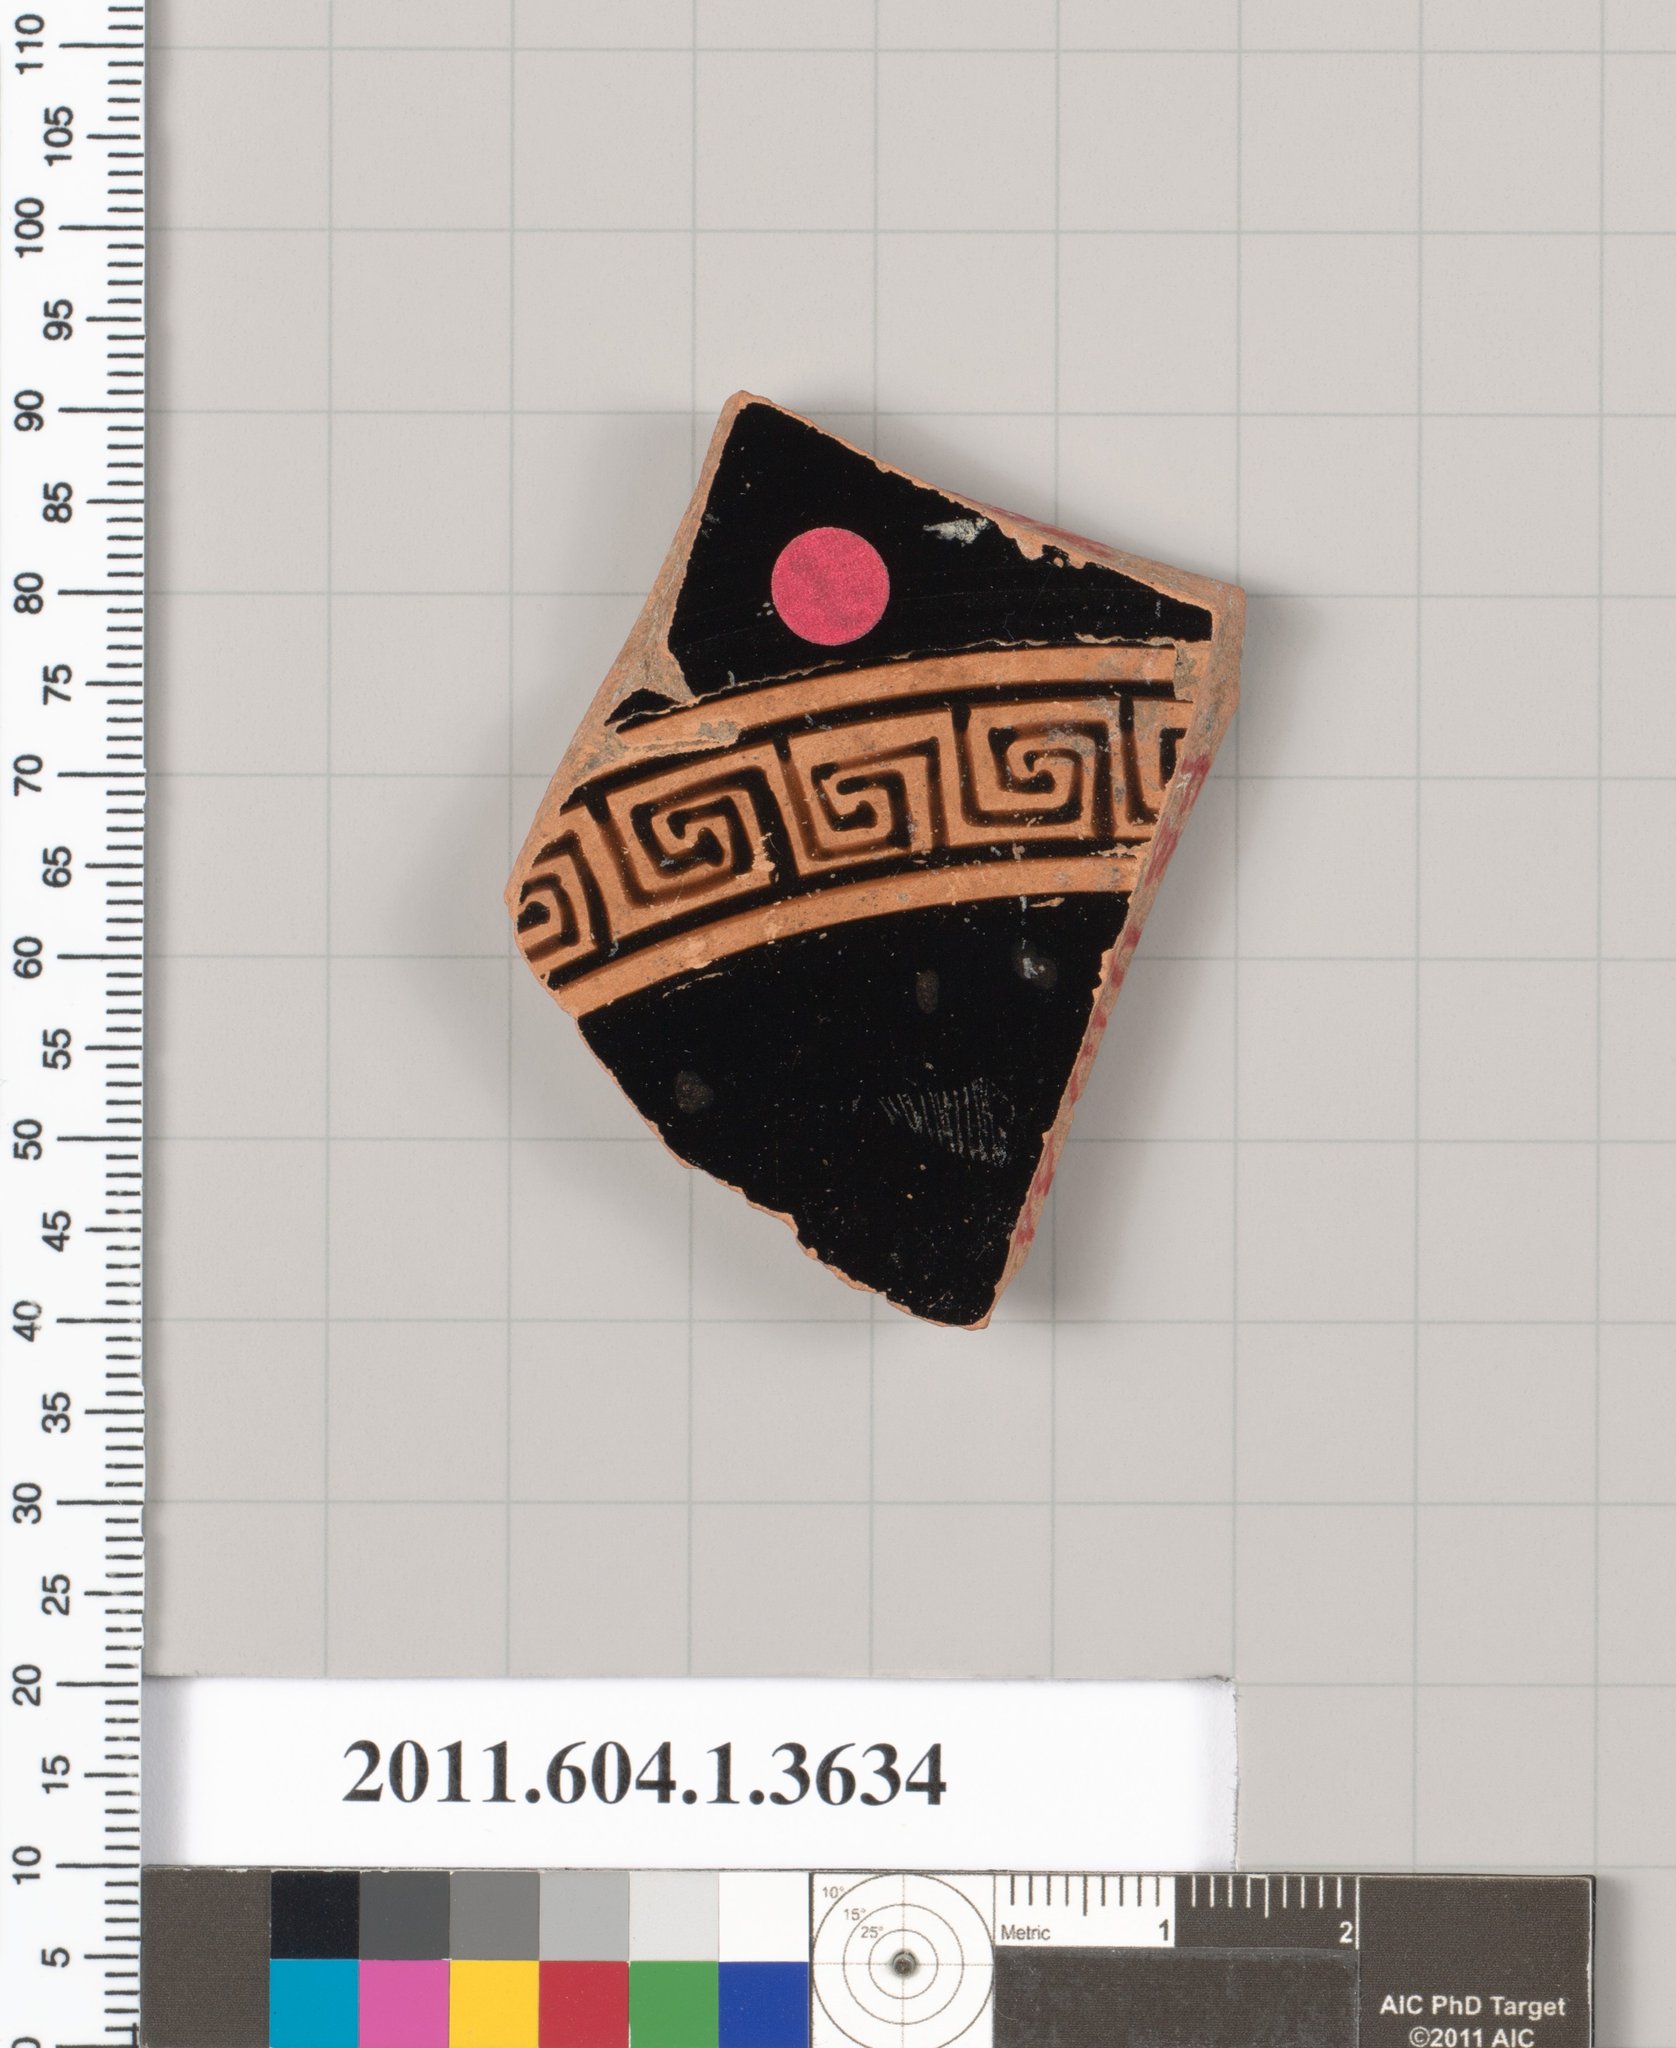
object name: kylix fragment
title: Terracotta fragment of a kylix (drinking cup)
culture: greek, attic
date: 500-470 BCE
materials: terracotta